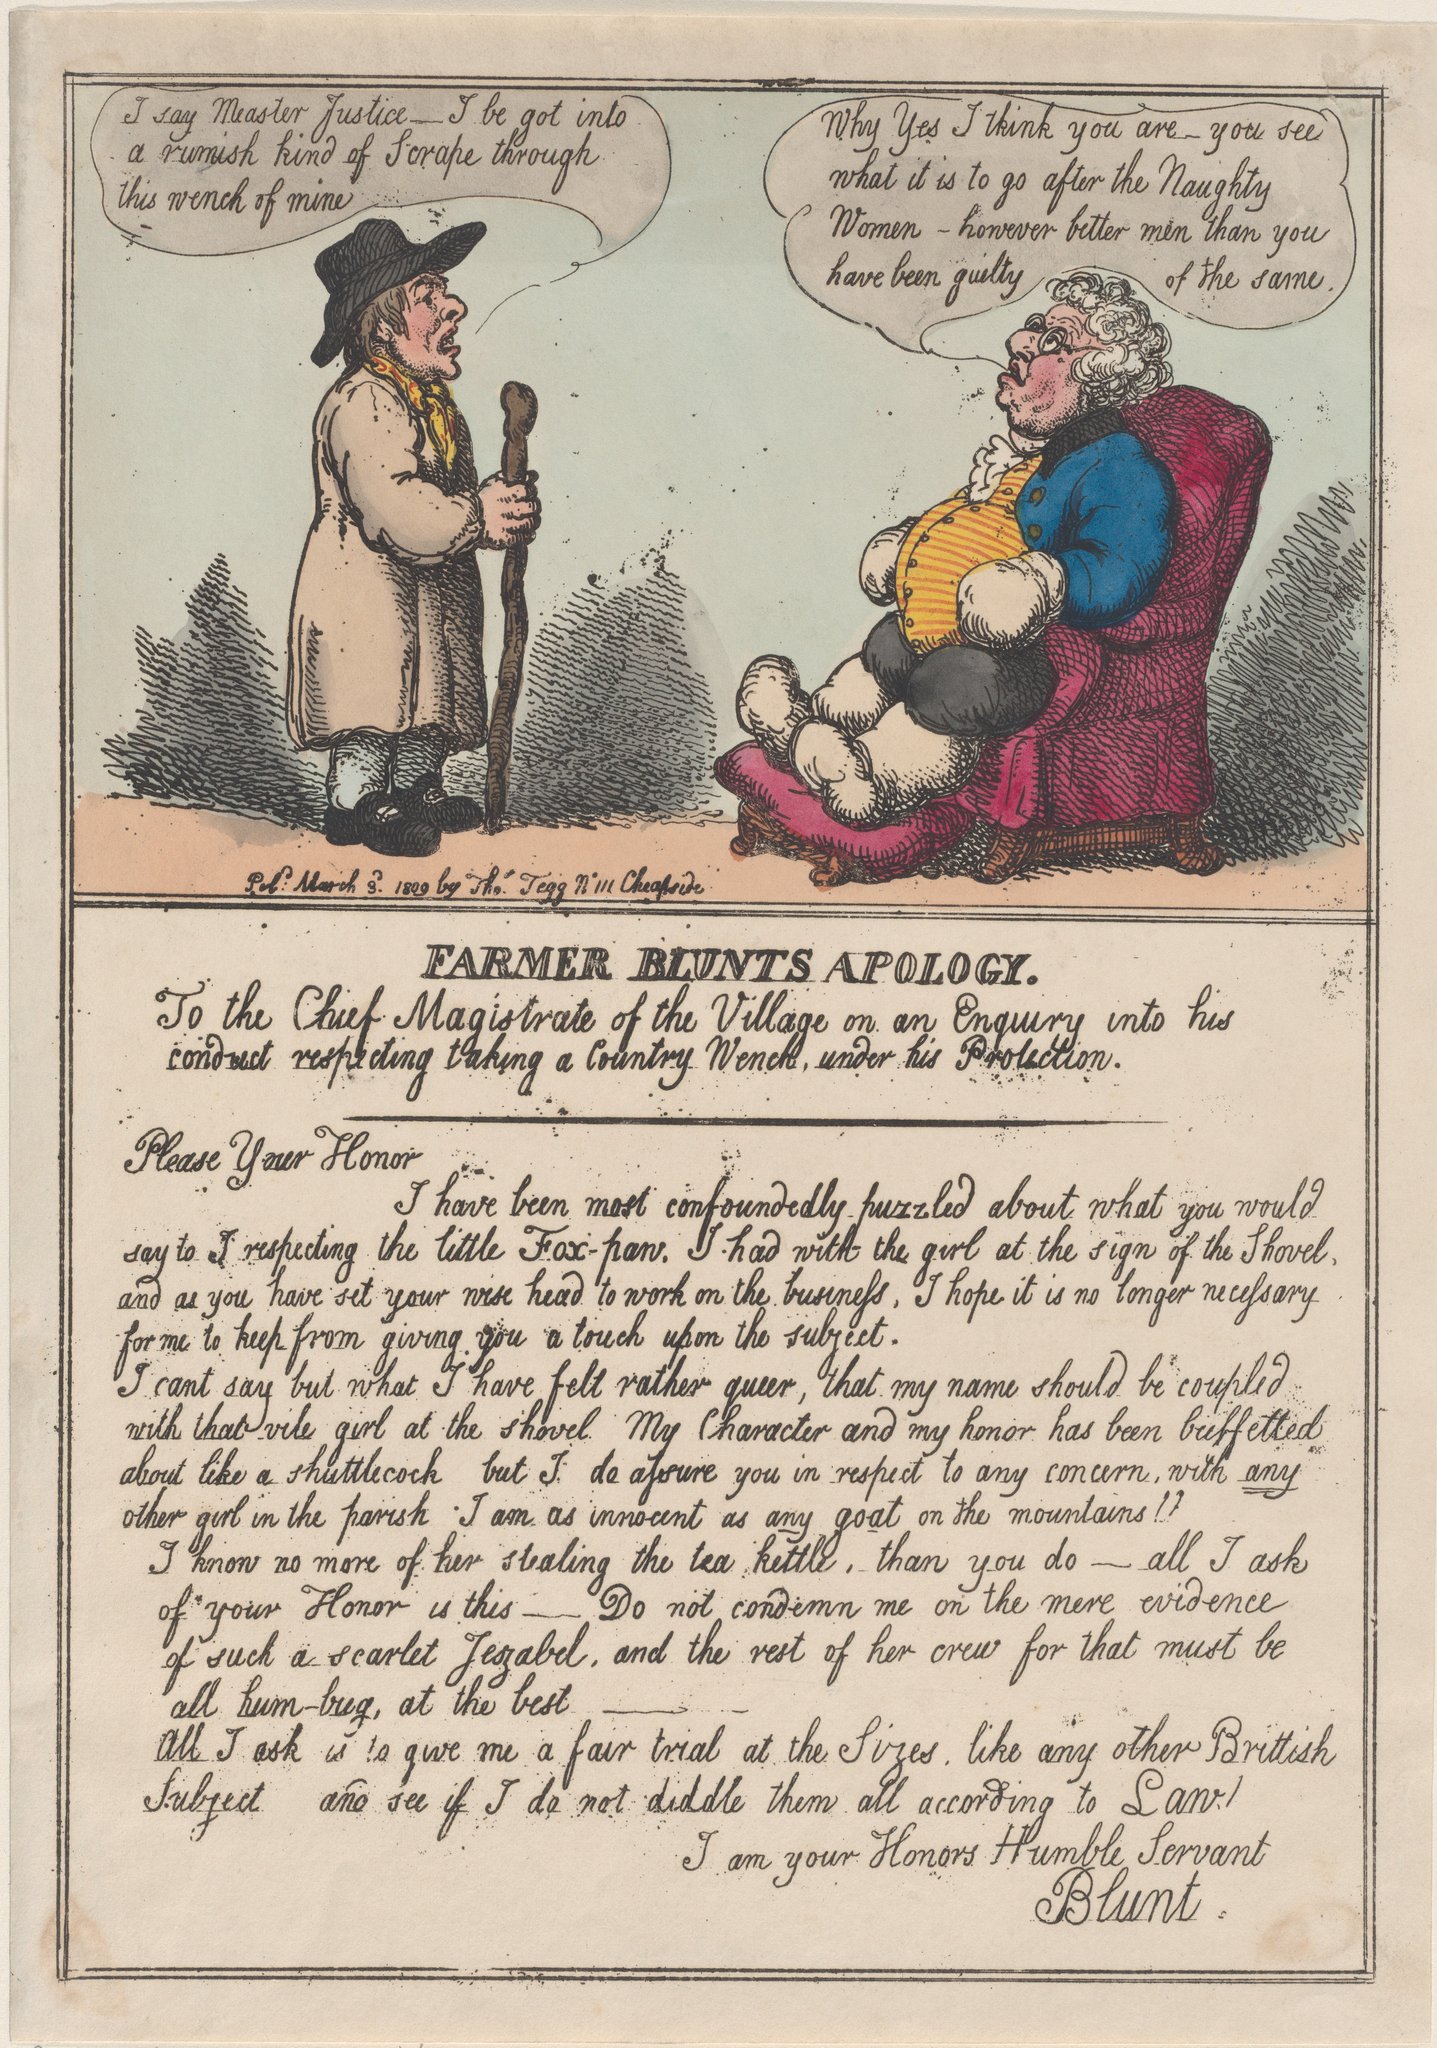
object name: print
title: Farmer Blunt's Apology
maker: thomas rowlandson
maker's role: artist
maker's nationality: british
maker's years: 1757-1827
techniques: etching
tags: satire,men,politics